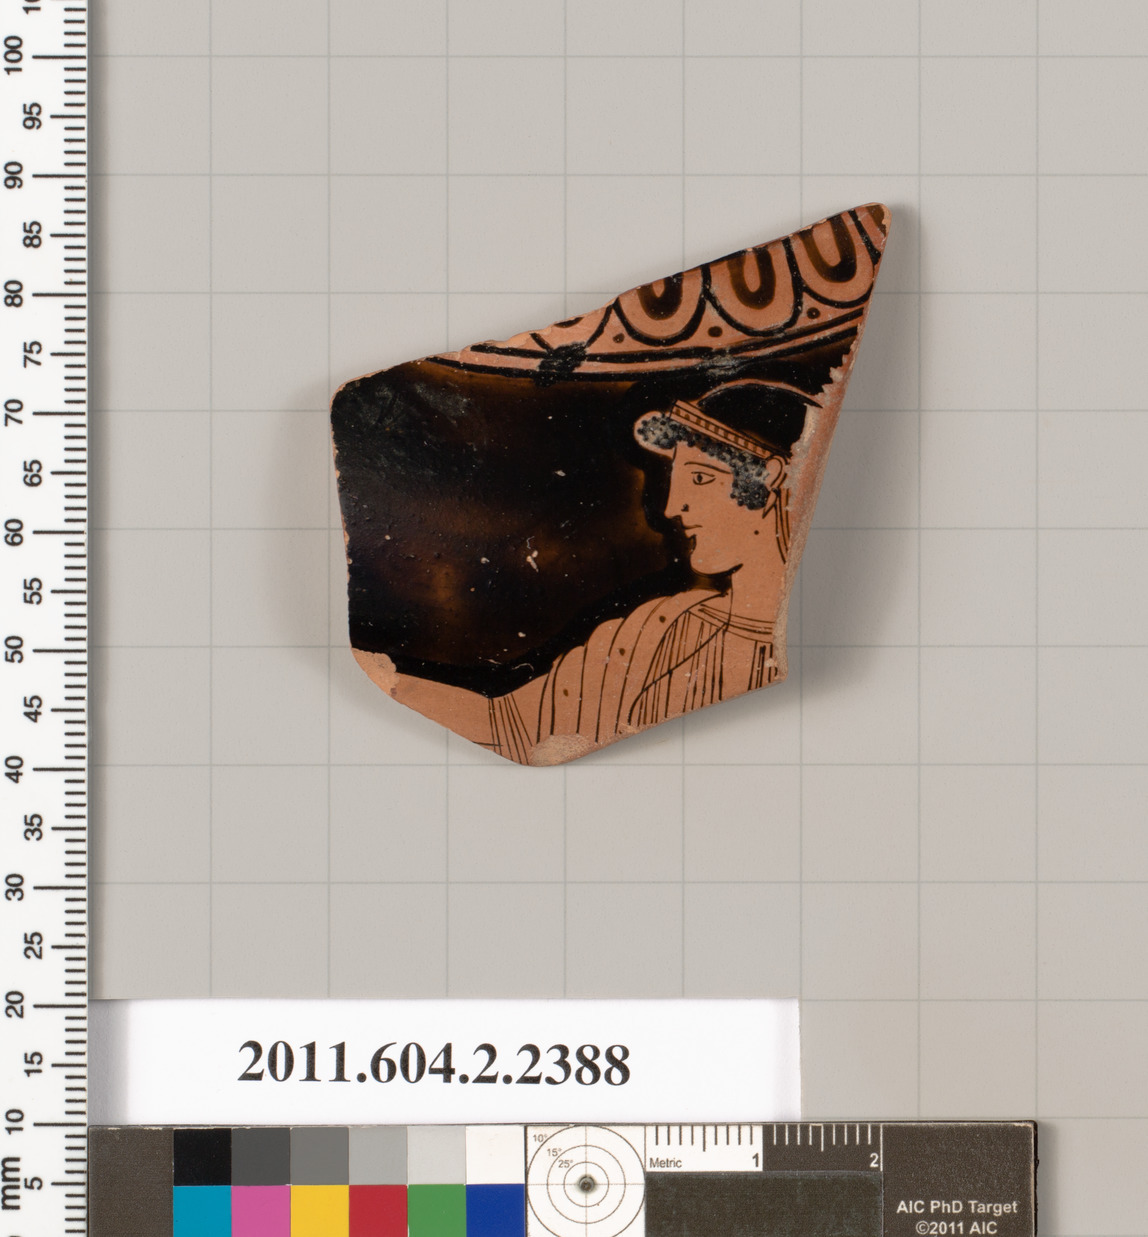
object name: oinochoe fragment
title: Terracotta fragment of an oinochoe (jug)?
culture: greek, attic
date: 490-470 BCE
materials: terracotta